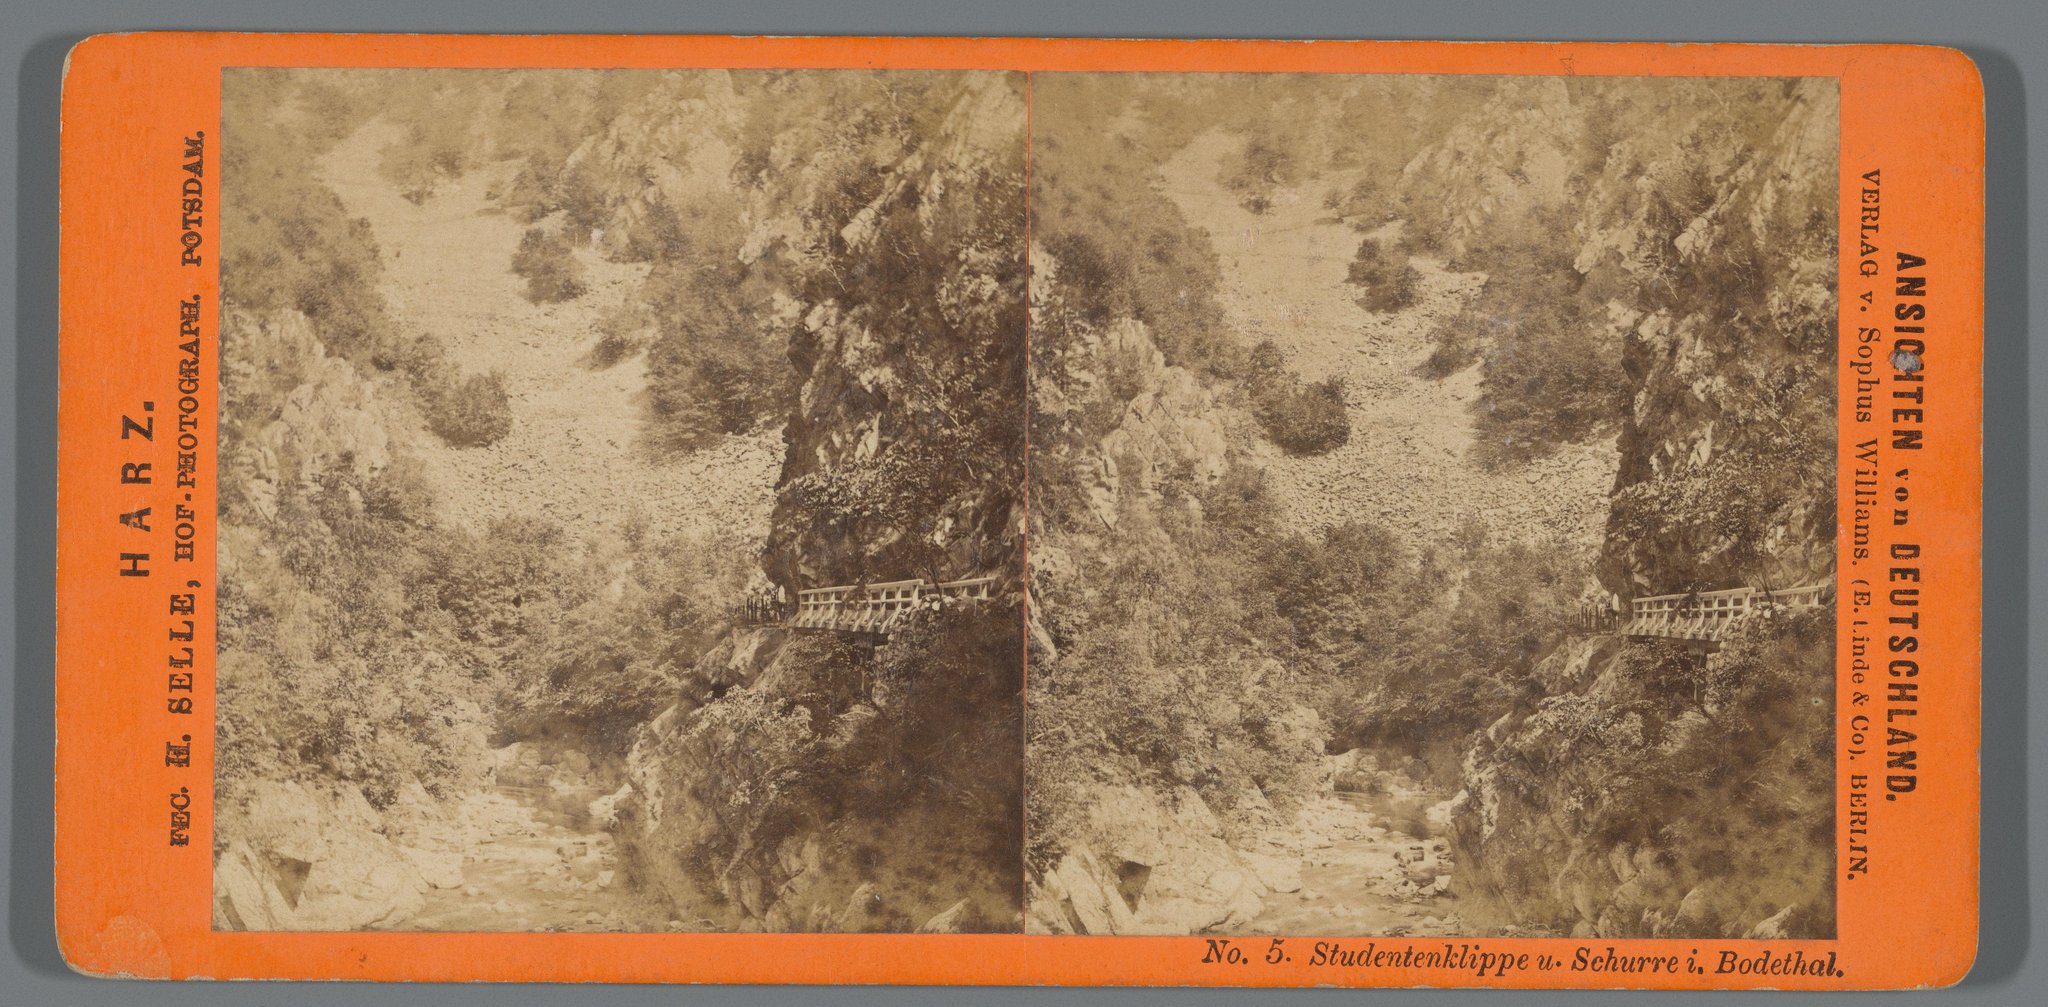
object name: stereograph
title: Ansichten von Deutschland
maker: hermann selle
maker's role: fotograaf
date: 1868-1880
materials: cardboard, paper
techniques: albumen print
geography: berlin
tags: ravine, chasm, abyss, canyon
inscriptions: number: ‘No. 5.’